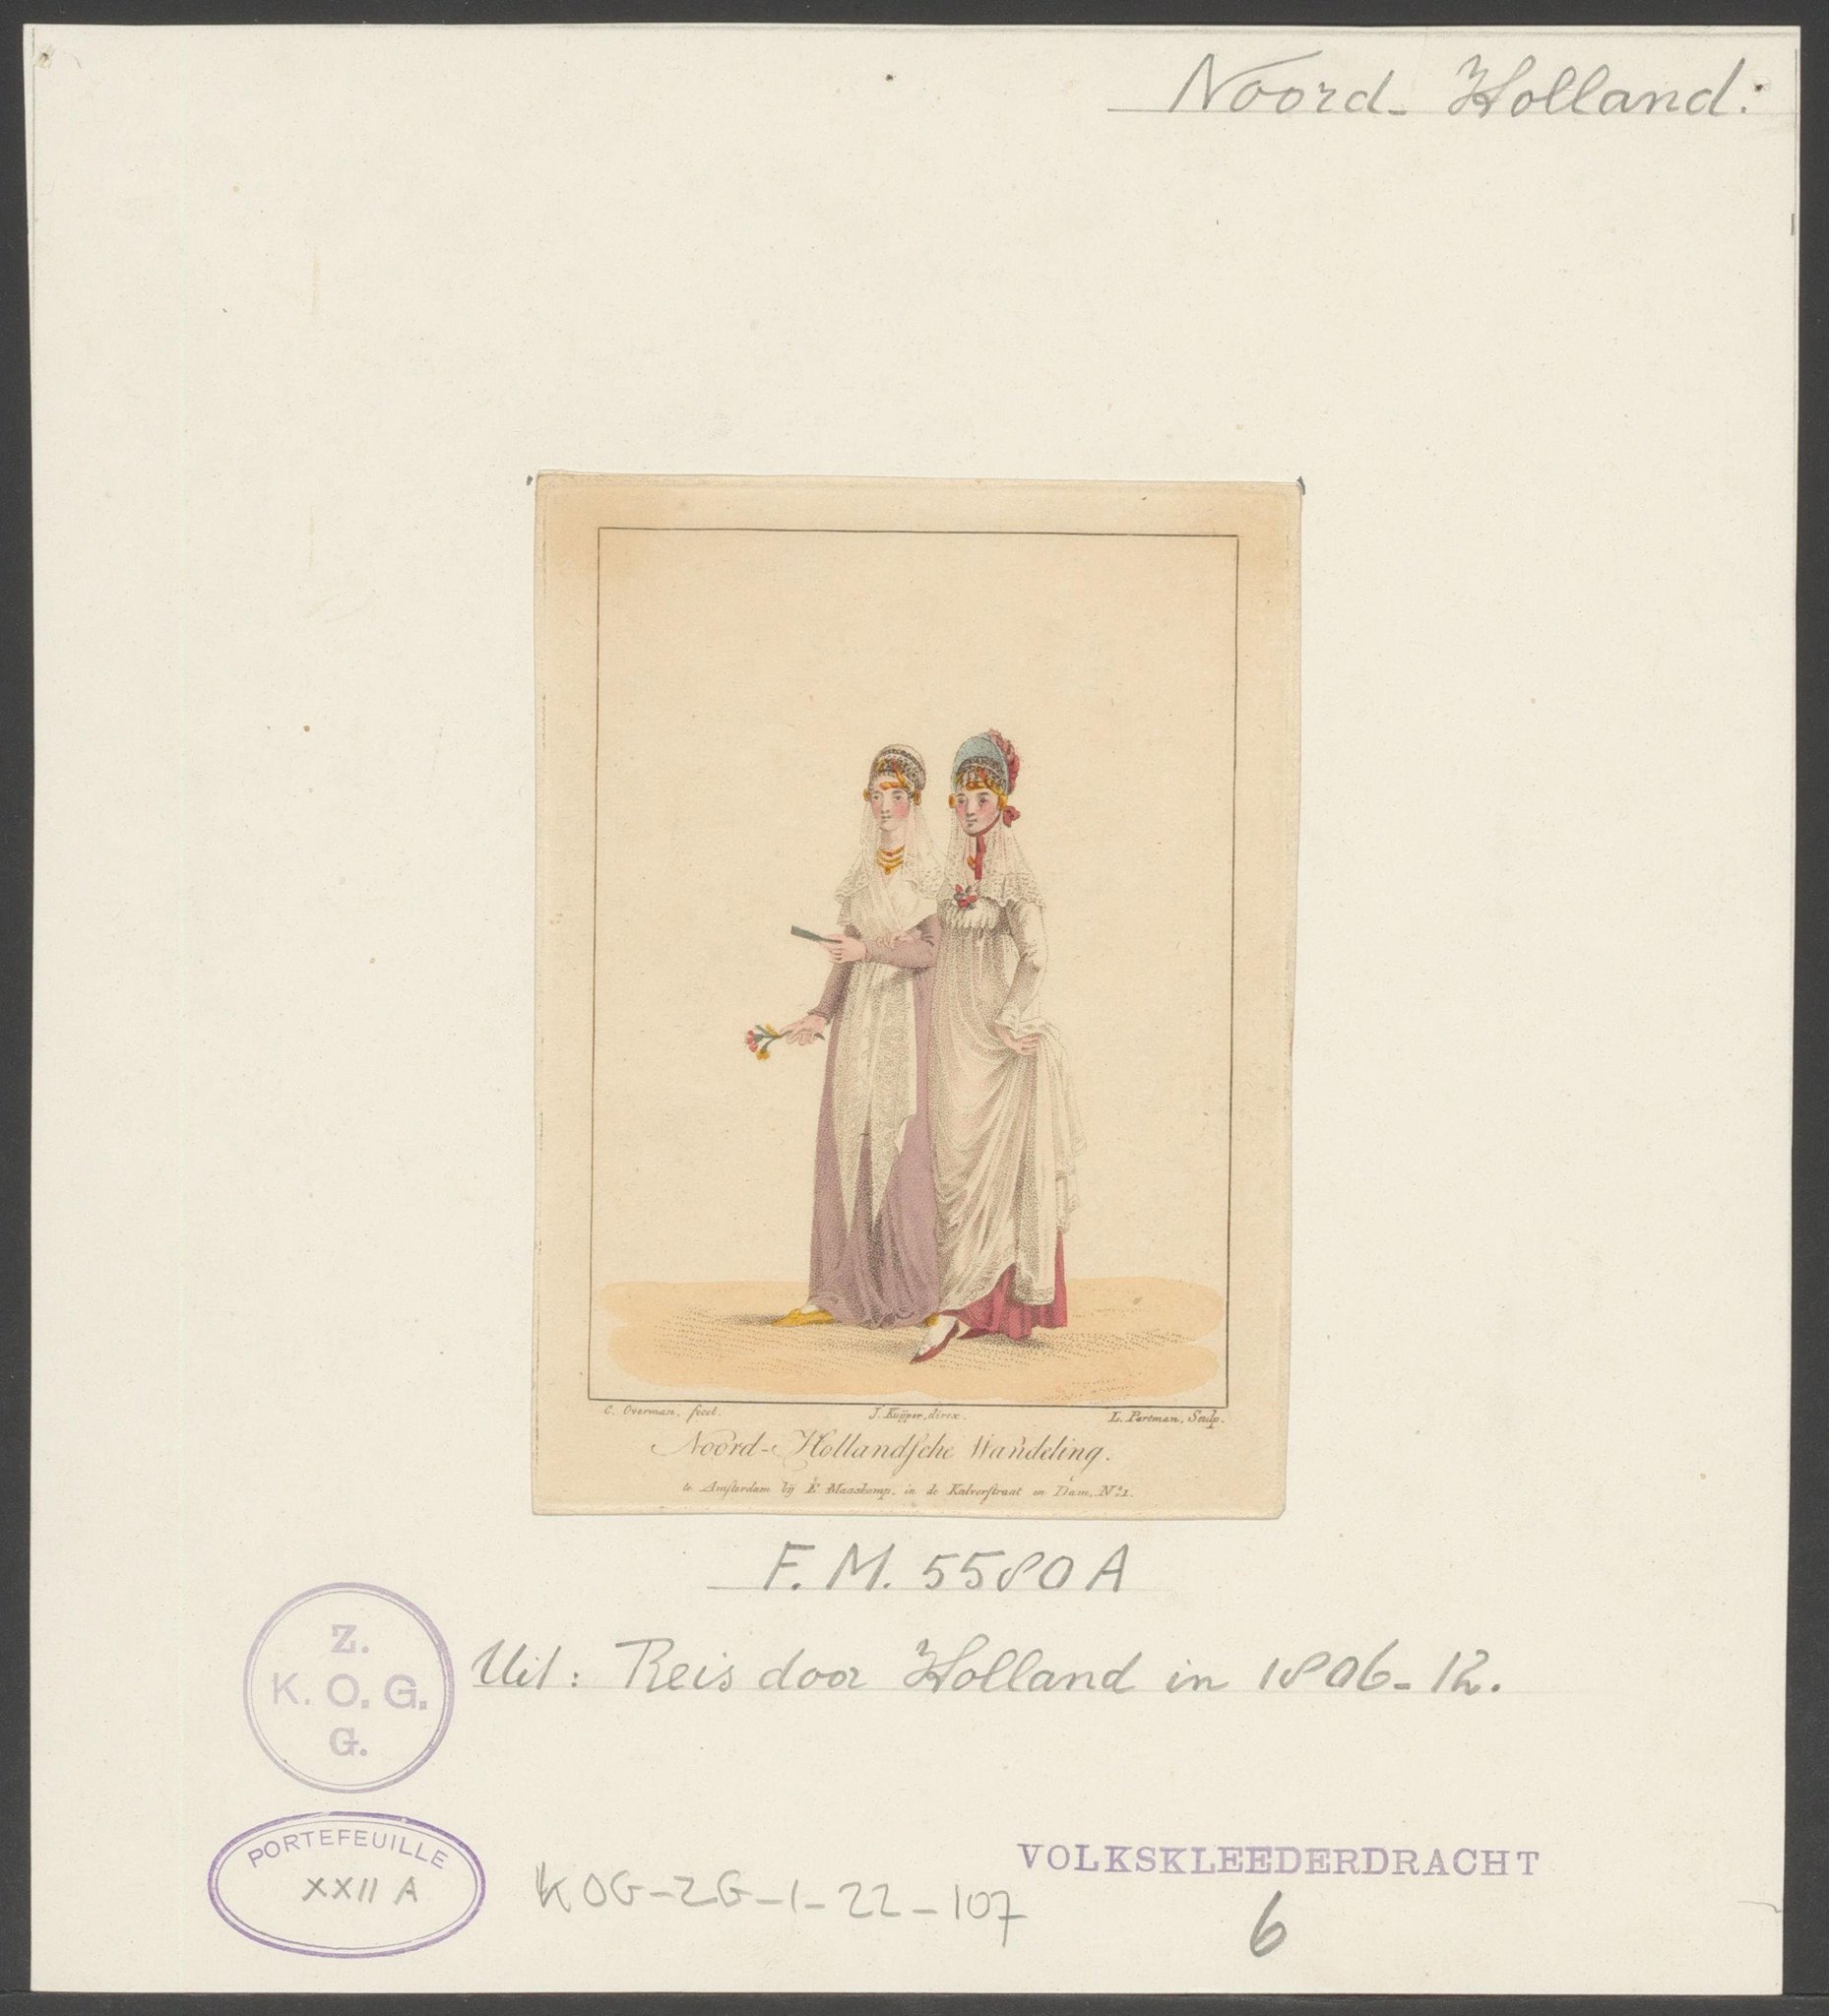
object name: book illustration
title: Twee meisjes uit Noord-Holland, wandelend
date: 1813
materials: paper, watercolor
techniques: etching, hand coloring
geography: netherlands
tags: clothes, costume (+ women's clothes), folk costume, regional costume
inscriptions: collector's mark: Lugt 1641, collector's mark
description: Twee meisjes uit Noord-Holland, wandelend arm in arm. Onderdeel van de verkleinde kopieën uit 1806 naar de platen van Nederlandse klederdrachten uit de jaren 1803-1807. Onderwerpsrubrieken binnen de Atlas Zeden en Gewoonten: De Kleeding, Volkskleederdracht, Noord-Holland.